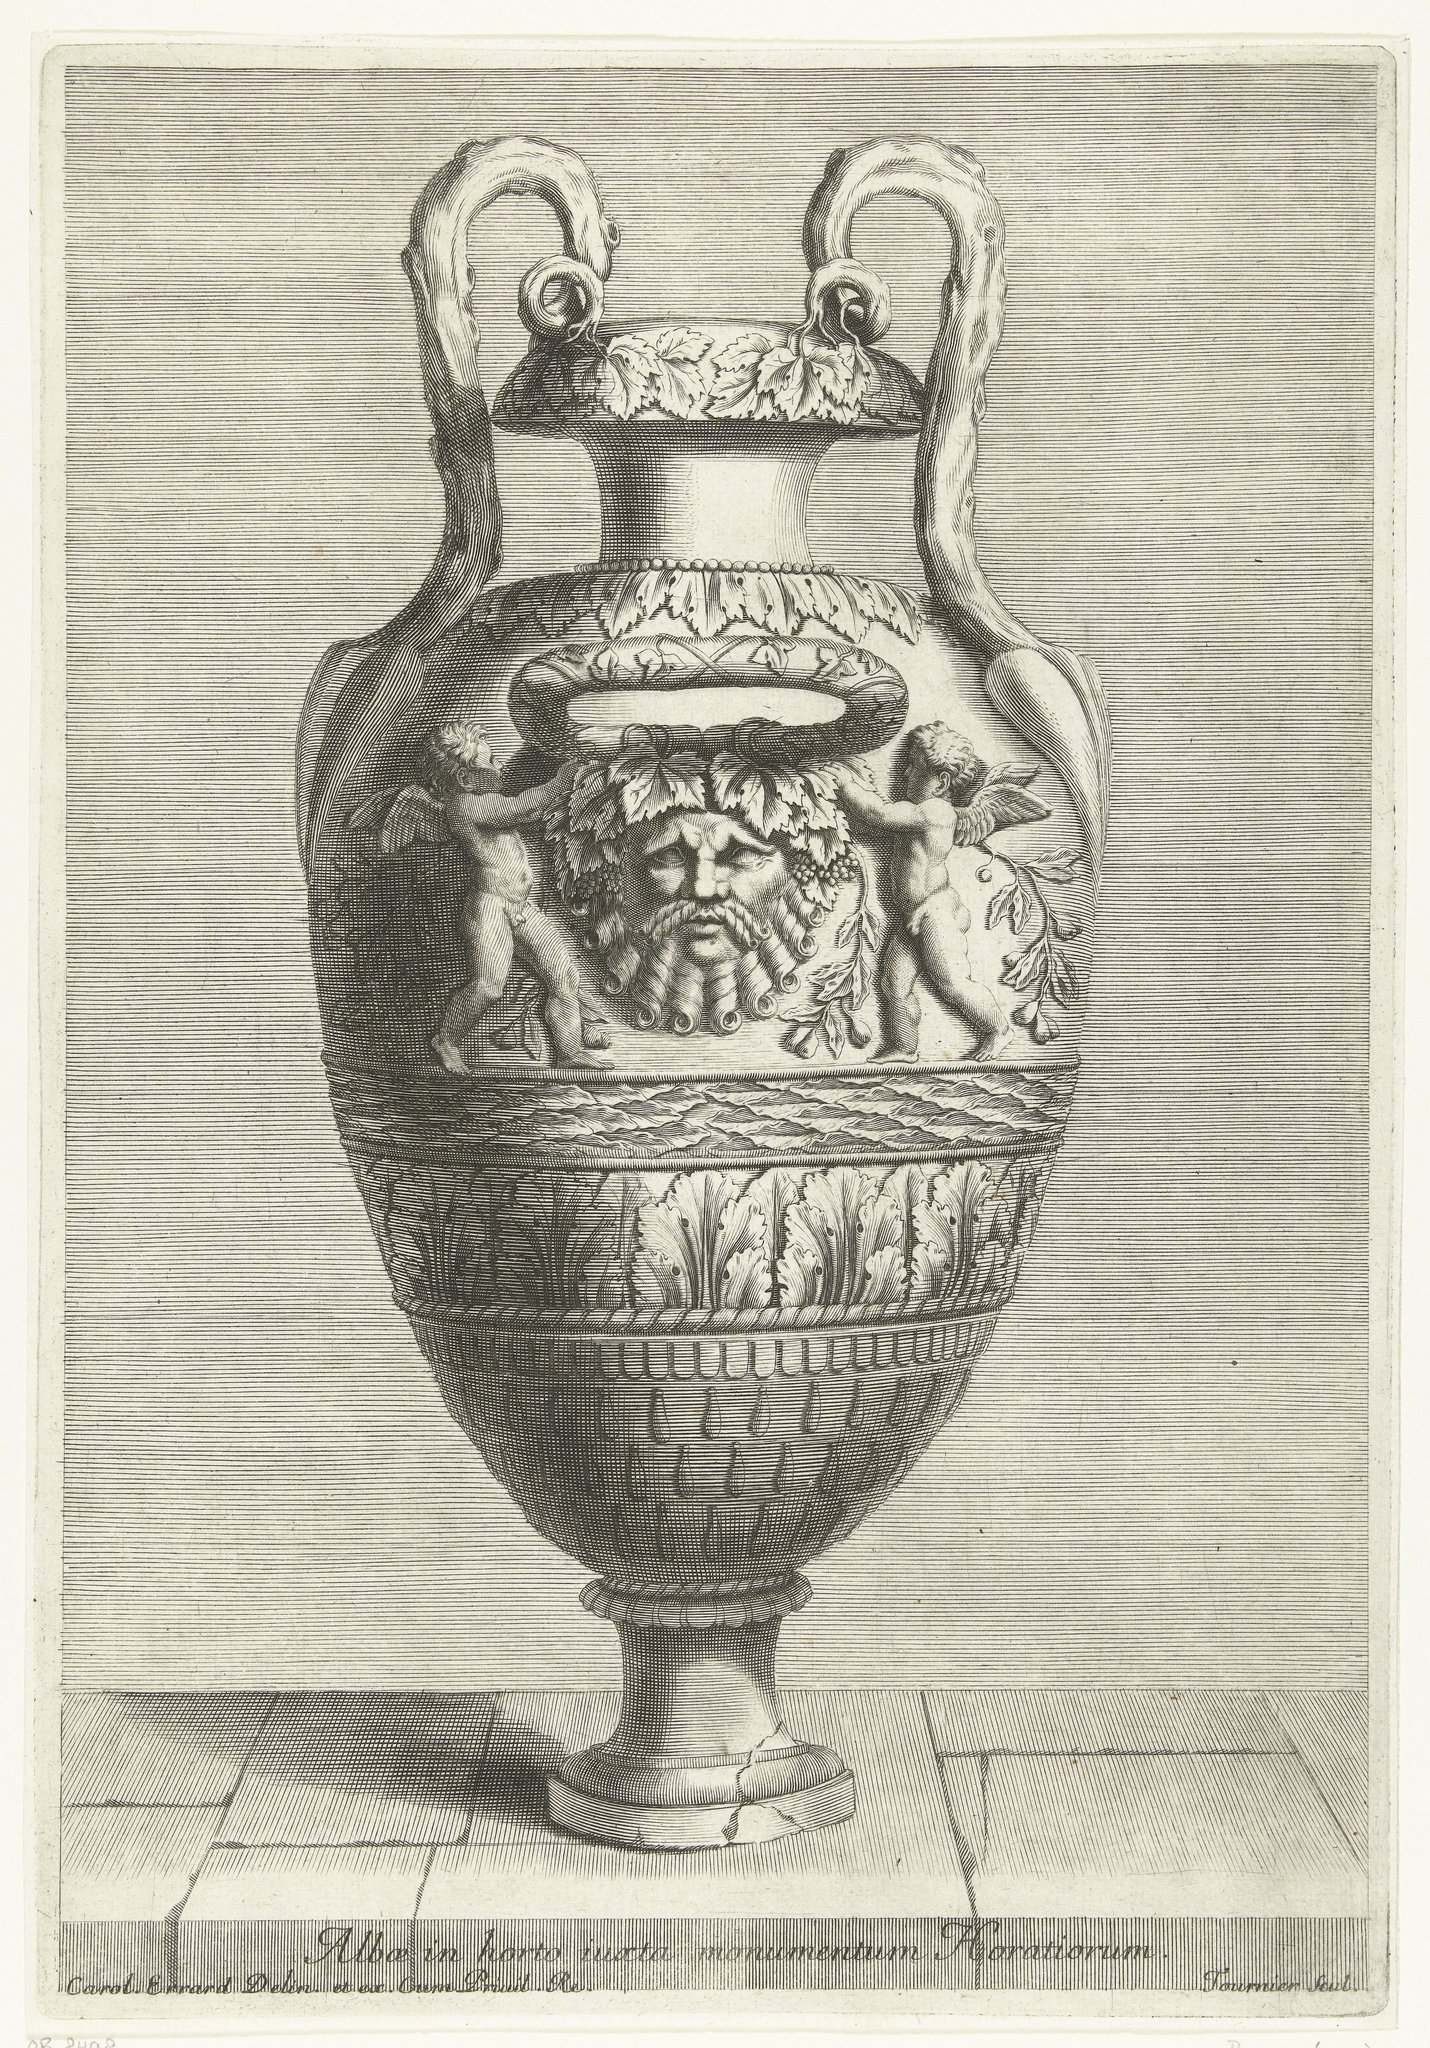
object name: ornament print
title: Vaas met twee handvatten in de vorm van boomstammen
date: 1650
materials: paper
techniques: engraving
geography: france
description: Op het lichaam rust een handvat op een masker met aan beide zijde een putto. Uit serie van 13 bladen.